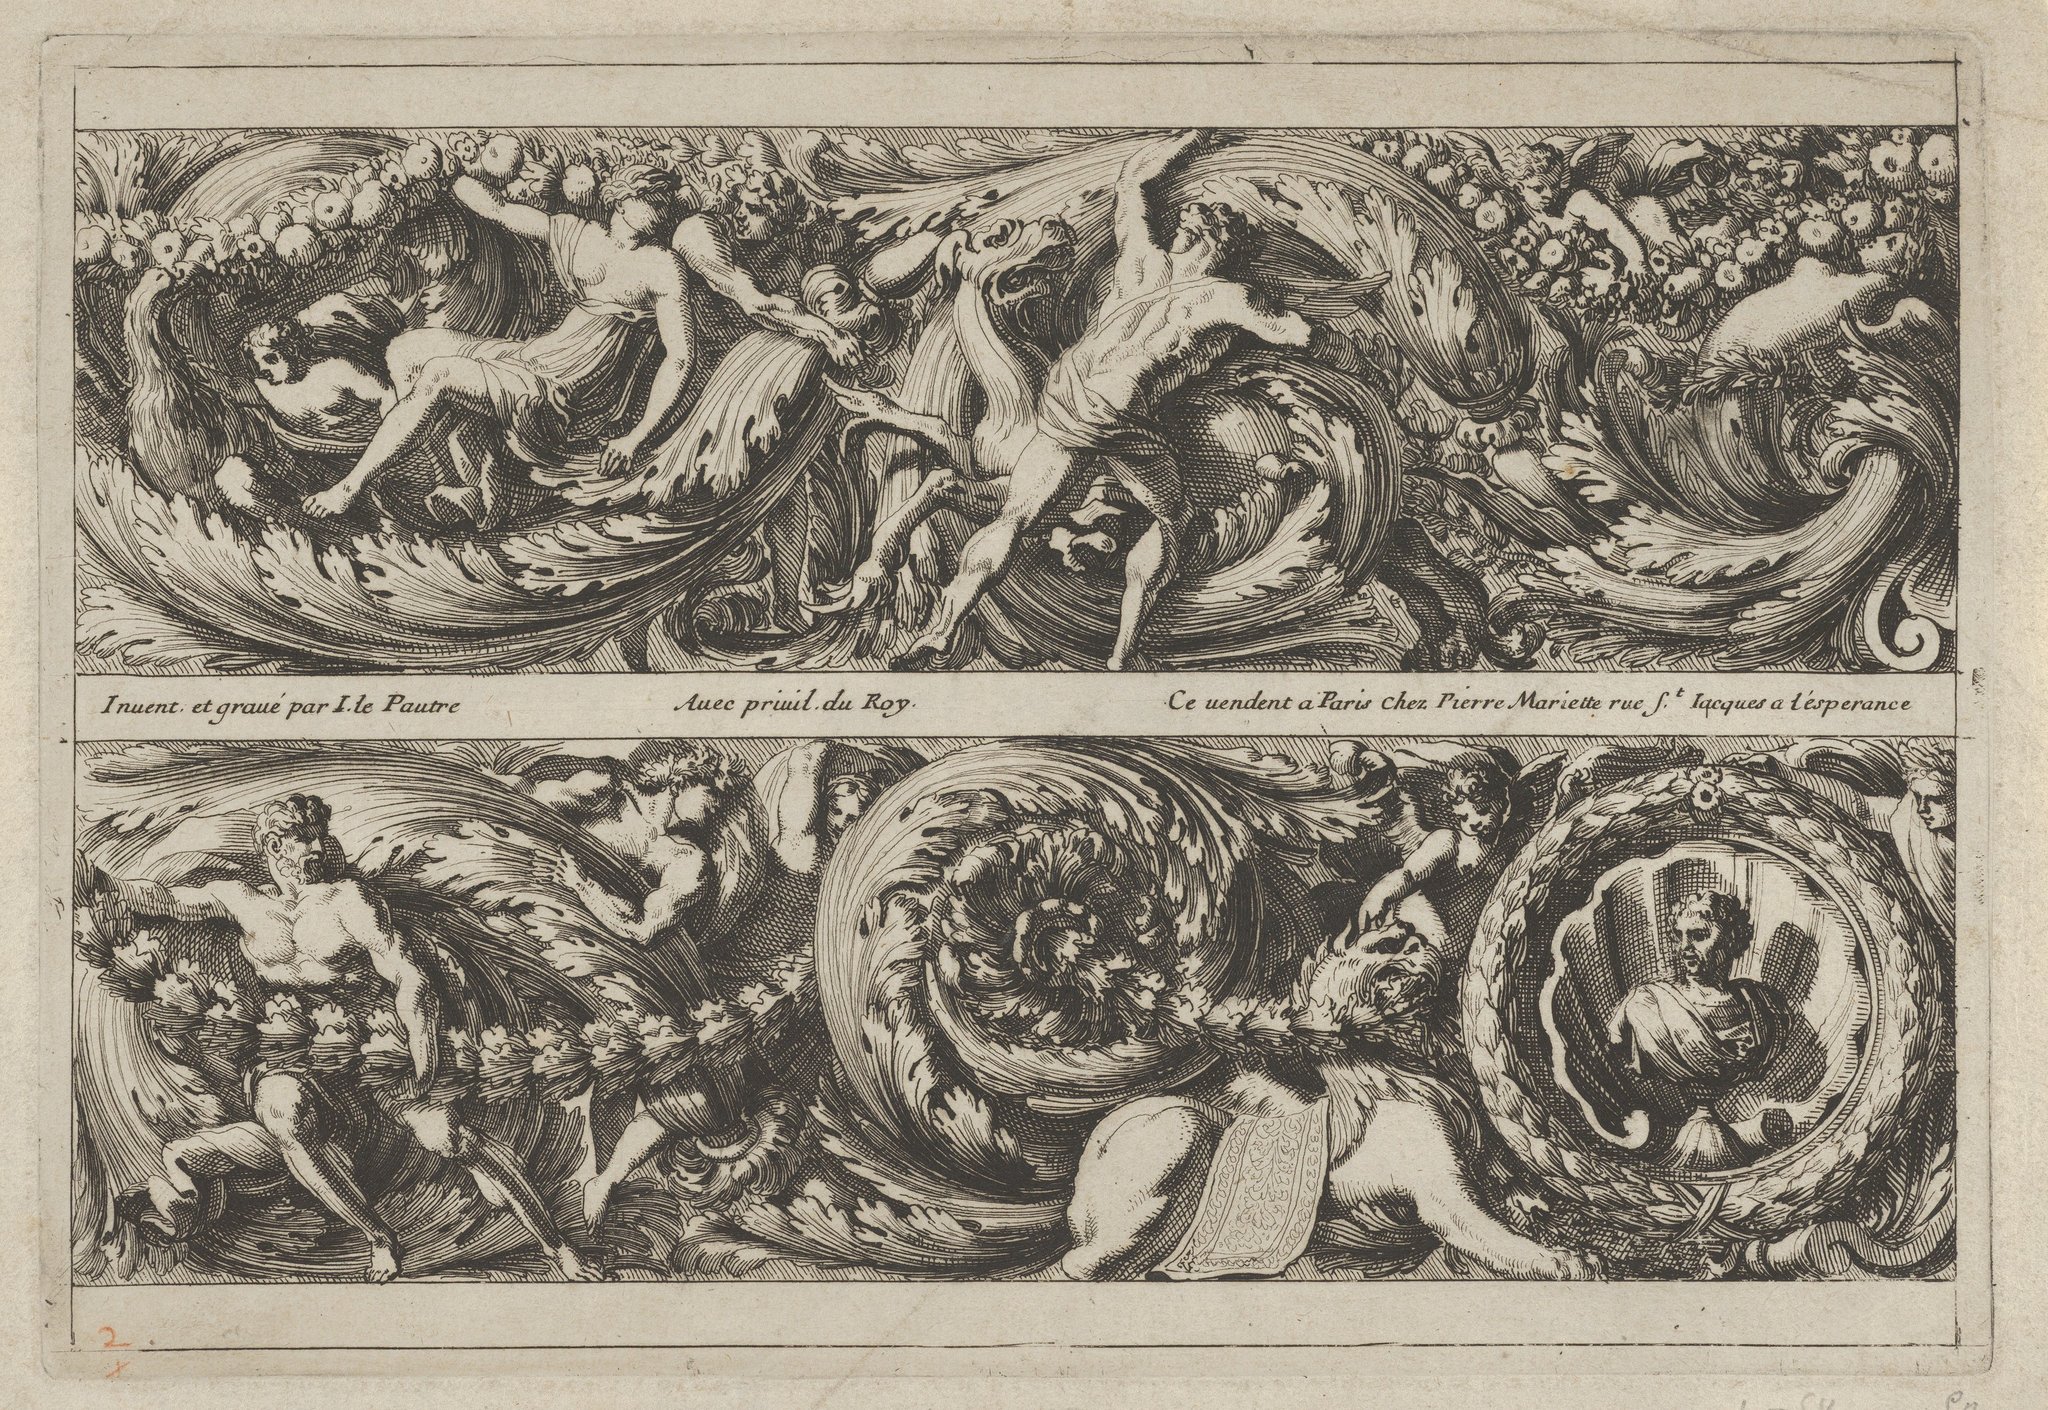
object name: print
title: Two Designs for Friezes with Acanthus Scrolls, from "Frises, Feuillages ou Tritons Marins à la romaine"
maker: jean le pautre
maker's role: artist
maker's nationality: french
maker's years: 1618-1682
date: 1640-1682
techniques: etching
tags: garlands,men,triton